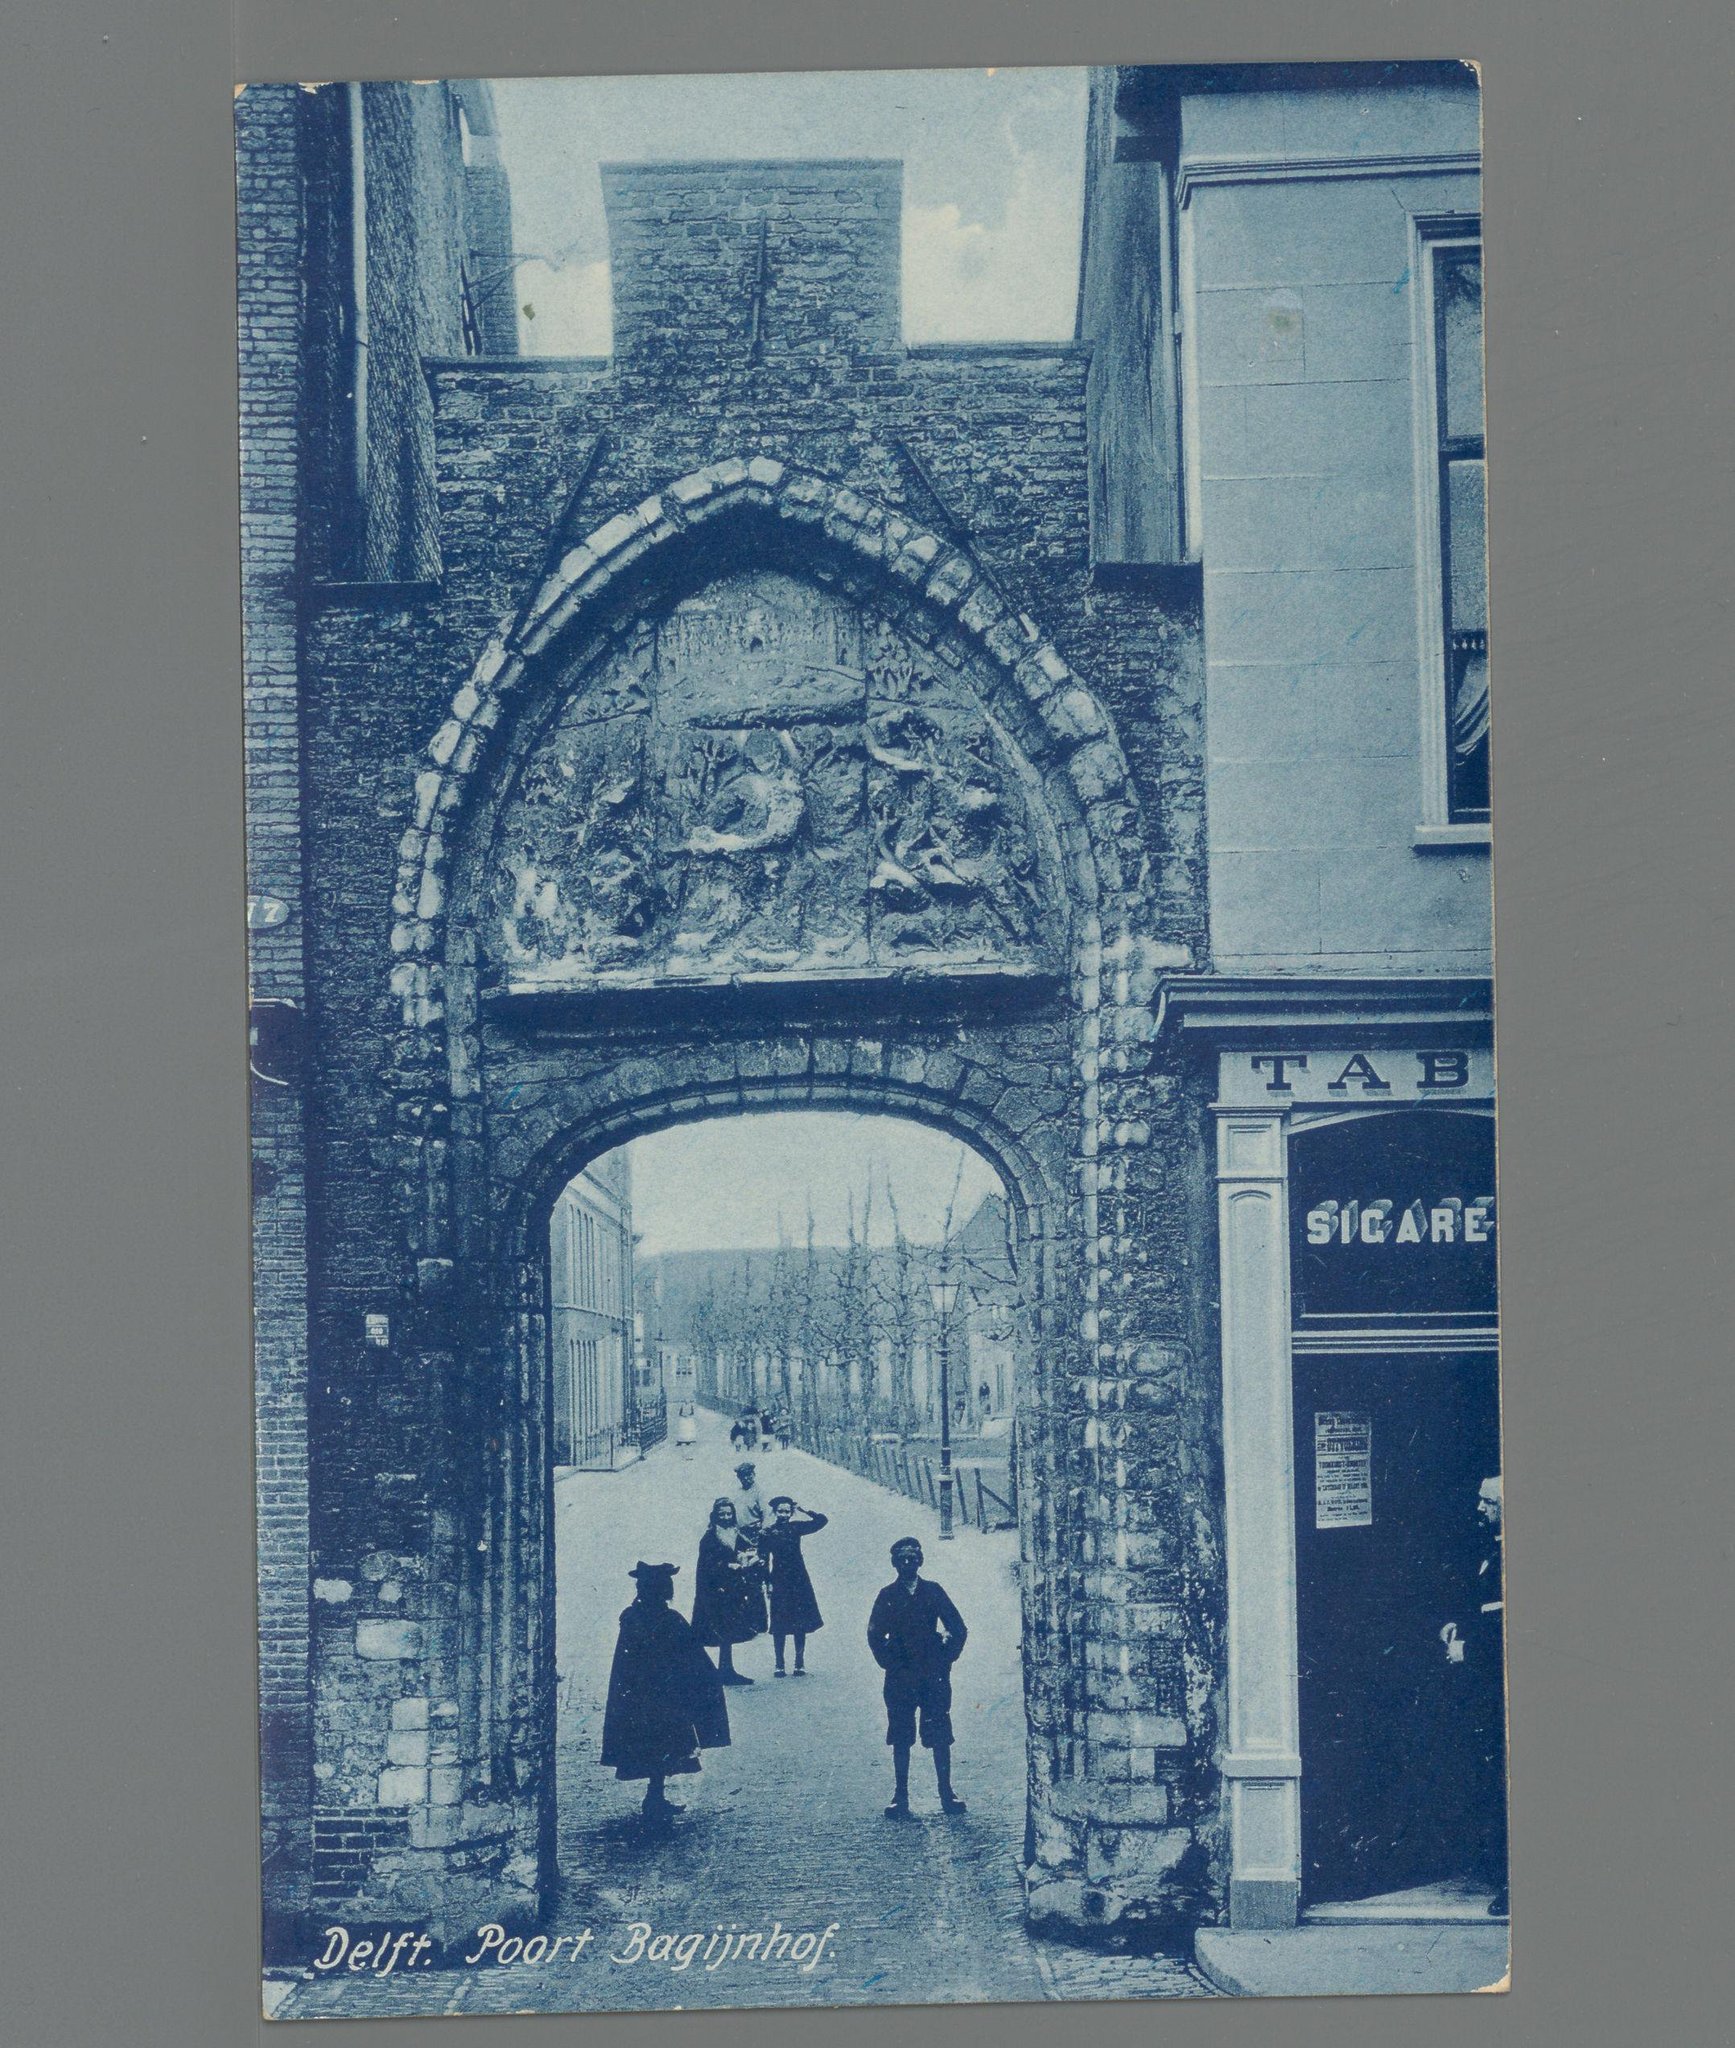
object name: ansichtkaart, prentbriefkaart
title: Delft. Poort Bagijnhof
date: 1906-1930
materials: cardboard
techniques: photograph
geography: delft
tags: alms-house (dutch: 'hofje'), city-gate